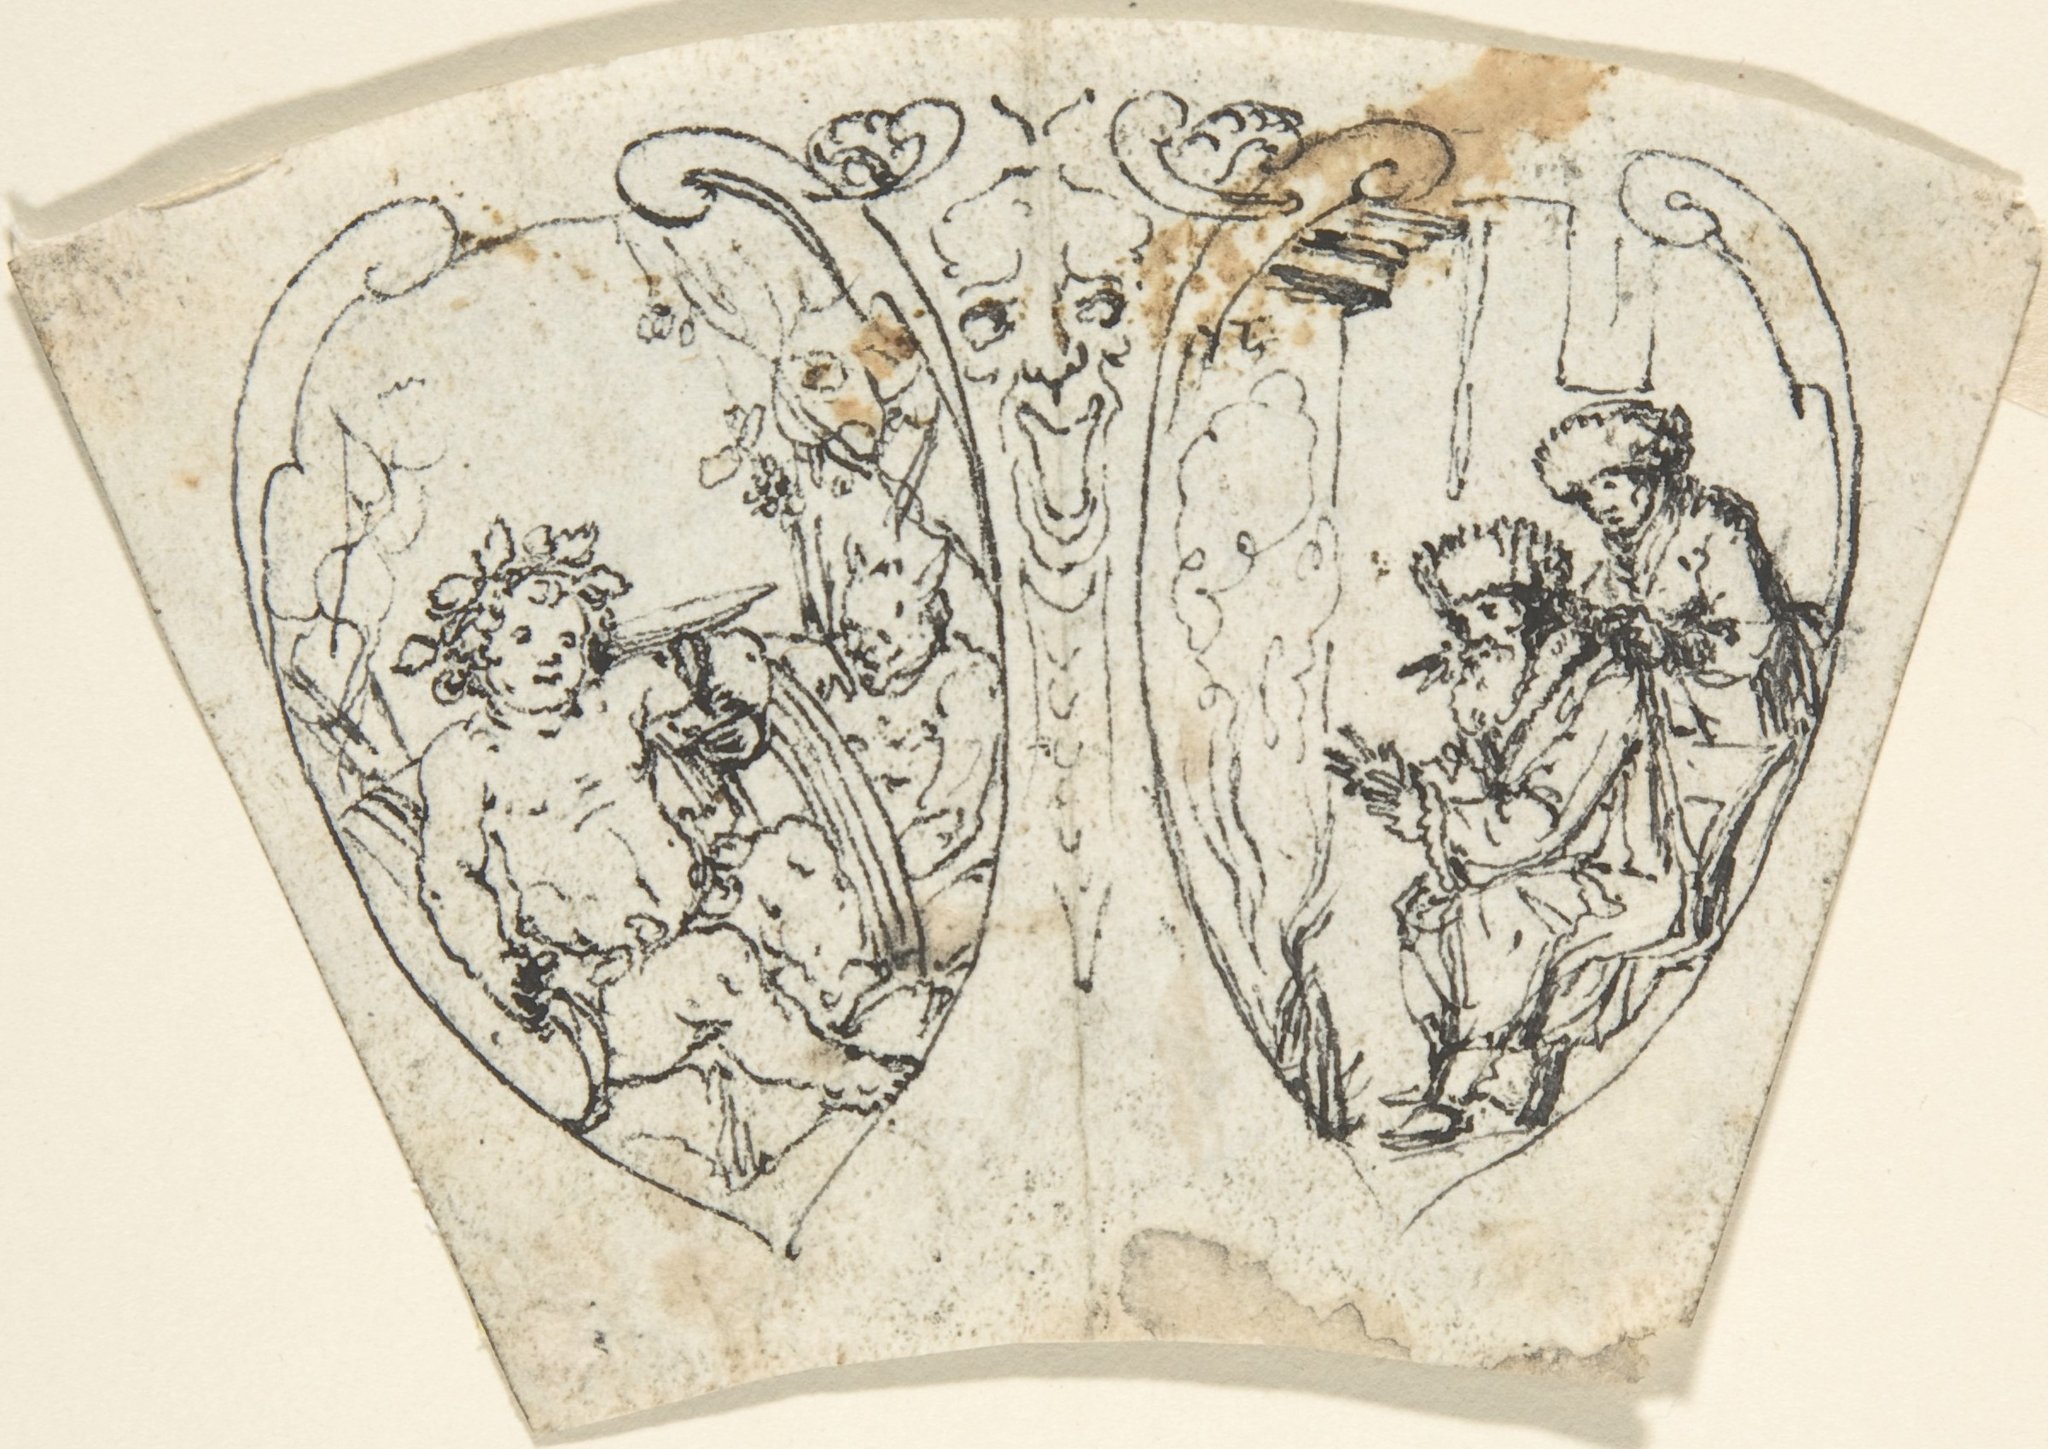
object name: drawing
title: Design for a Cup (?) with Bacchus and Two Figures Warming Themselves (January)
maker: anonymous, german, 19th century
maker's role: artist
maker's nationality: german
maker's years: 1800-1899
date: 1801-1900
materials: ink, paper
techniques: incising, pen, transfer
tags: men,bacchus,fire